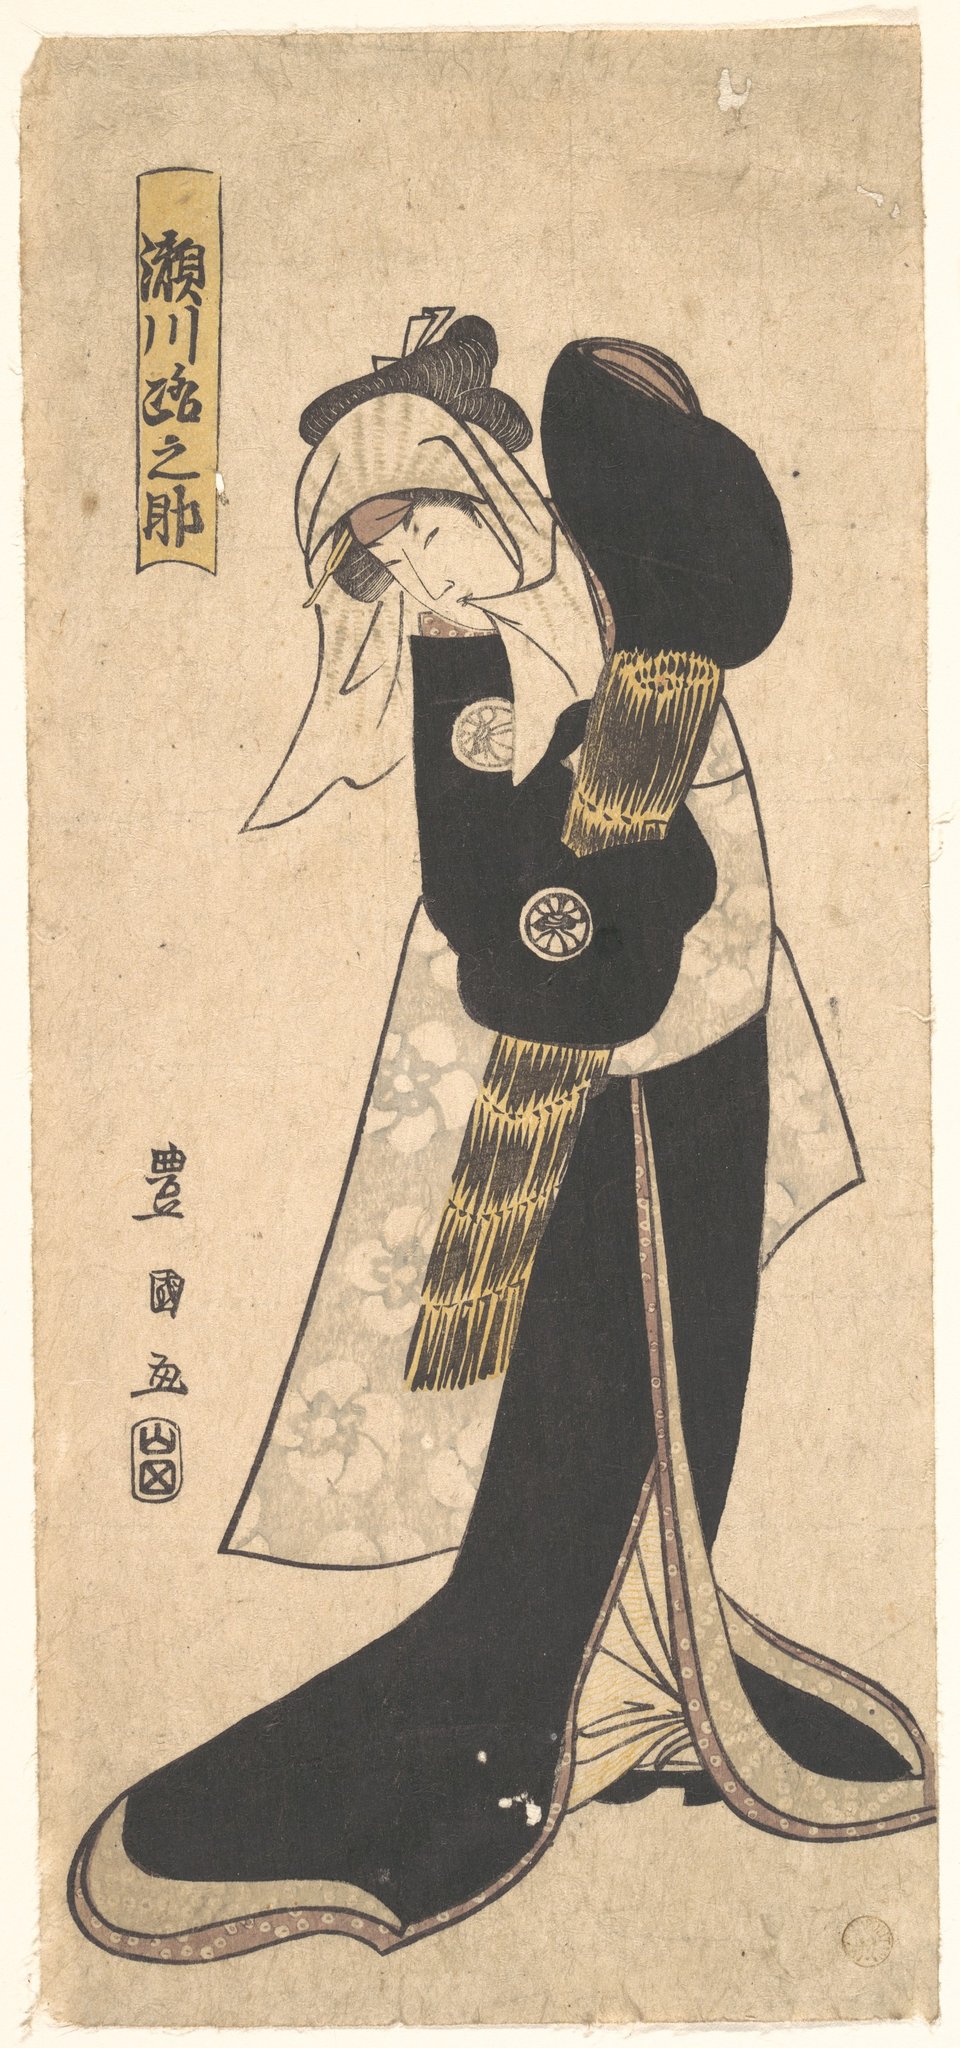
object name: woodblock print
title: The Actor Segawa Kikunojo III as a Woman in Black Robe Holding a Straw Hat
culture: japanese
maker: utagawa toyokuni i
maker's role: artist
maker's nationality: japanese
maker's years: 1769-1825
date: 1798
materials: ink, paper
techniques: woodblock print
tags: actors